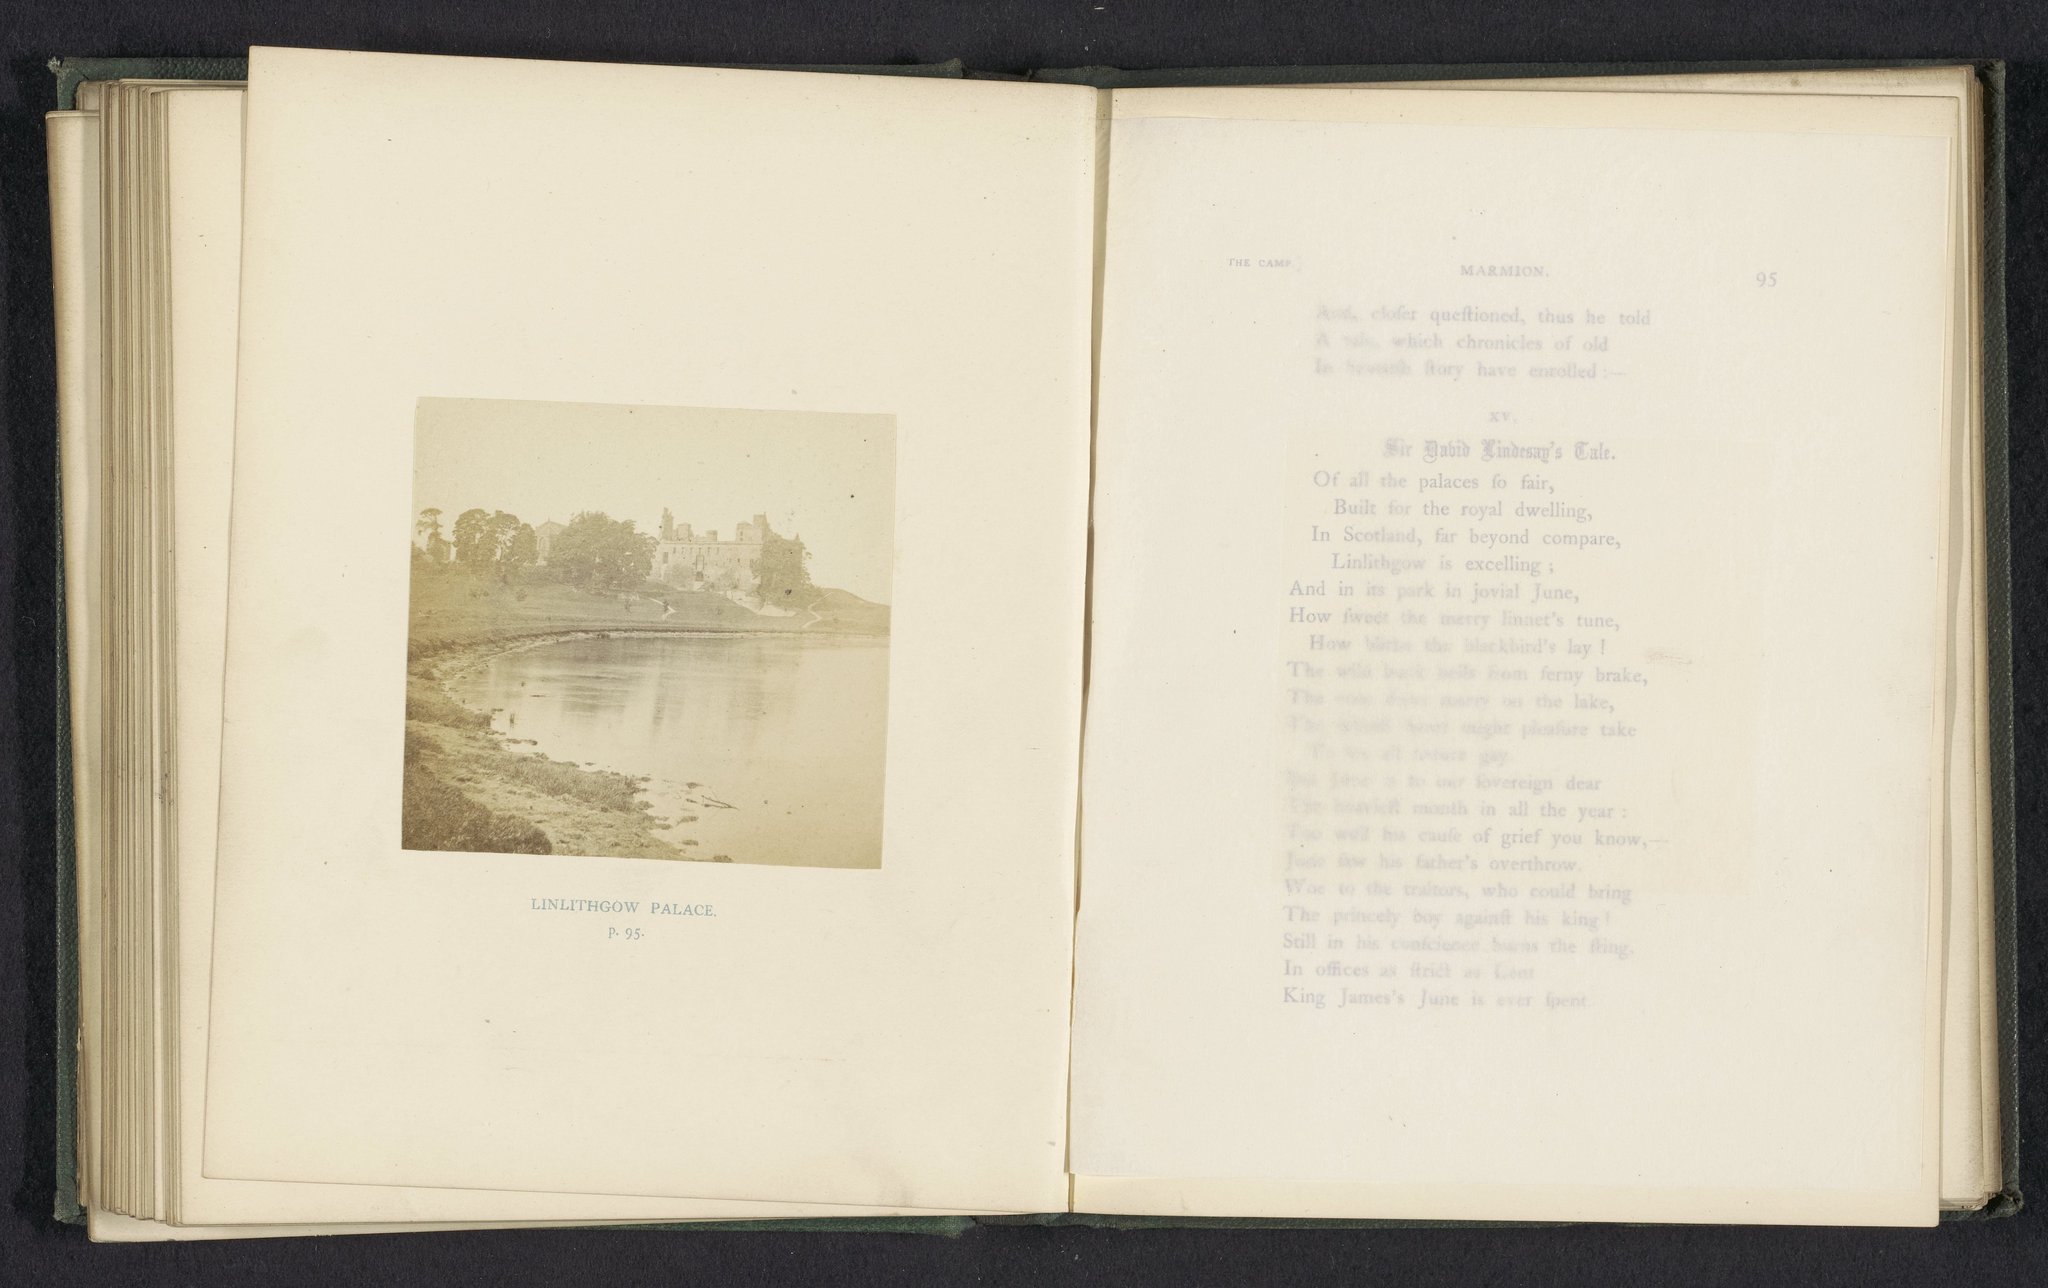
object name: page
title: Linlithgow Palace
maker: thomas annan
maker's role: fotograaf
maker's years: 1829-1887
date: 1861-1866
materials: photographic support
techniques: albumen print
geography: west lothian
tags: castle